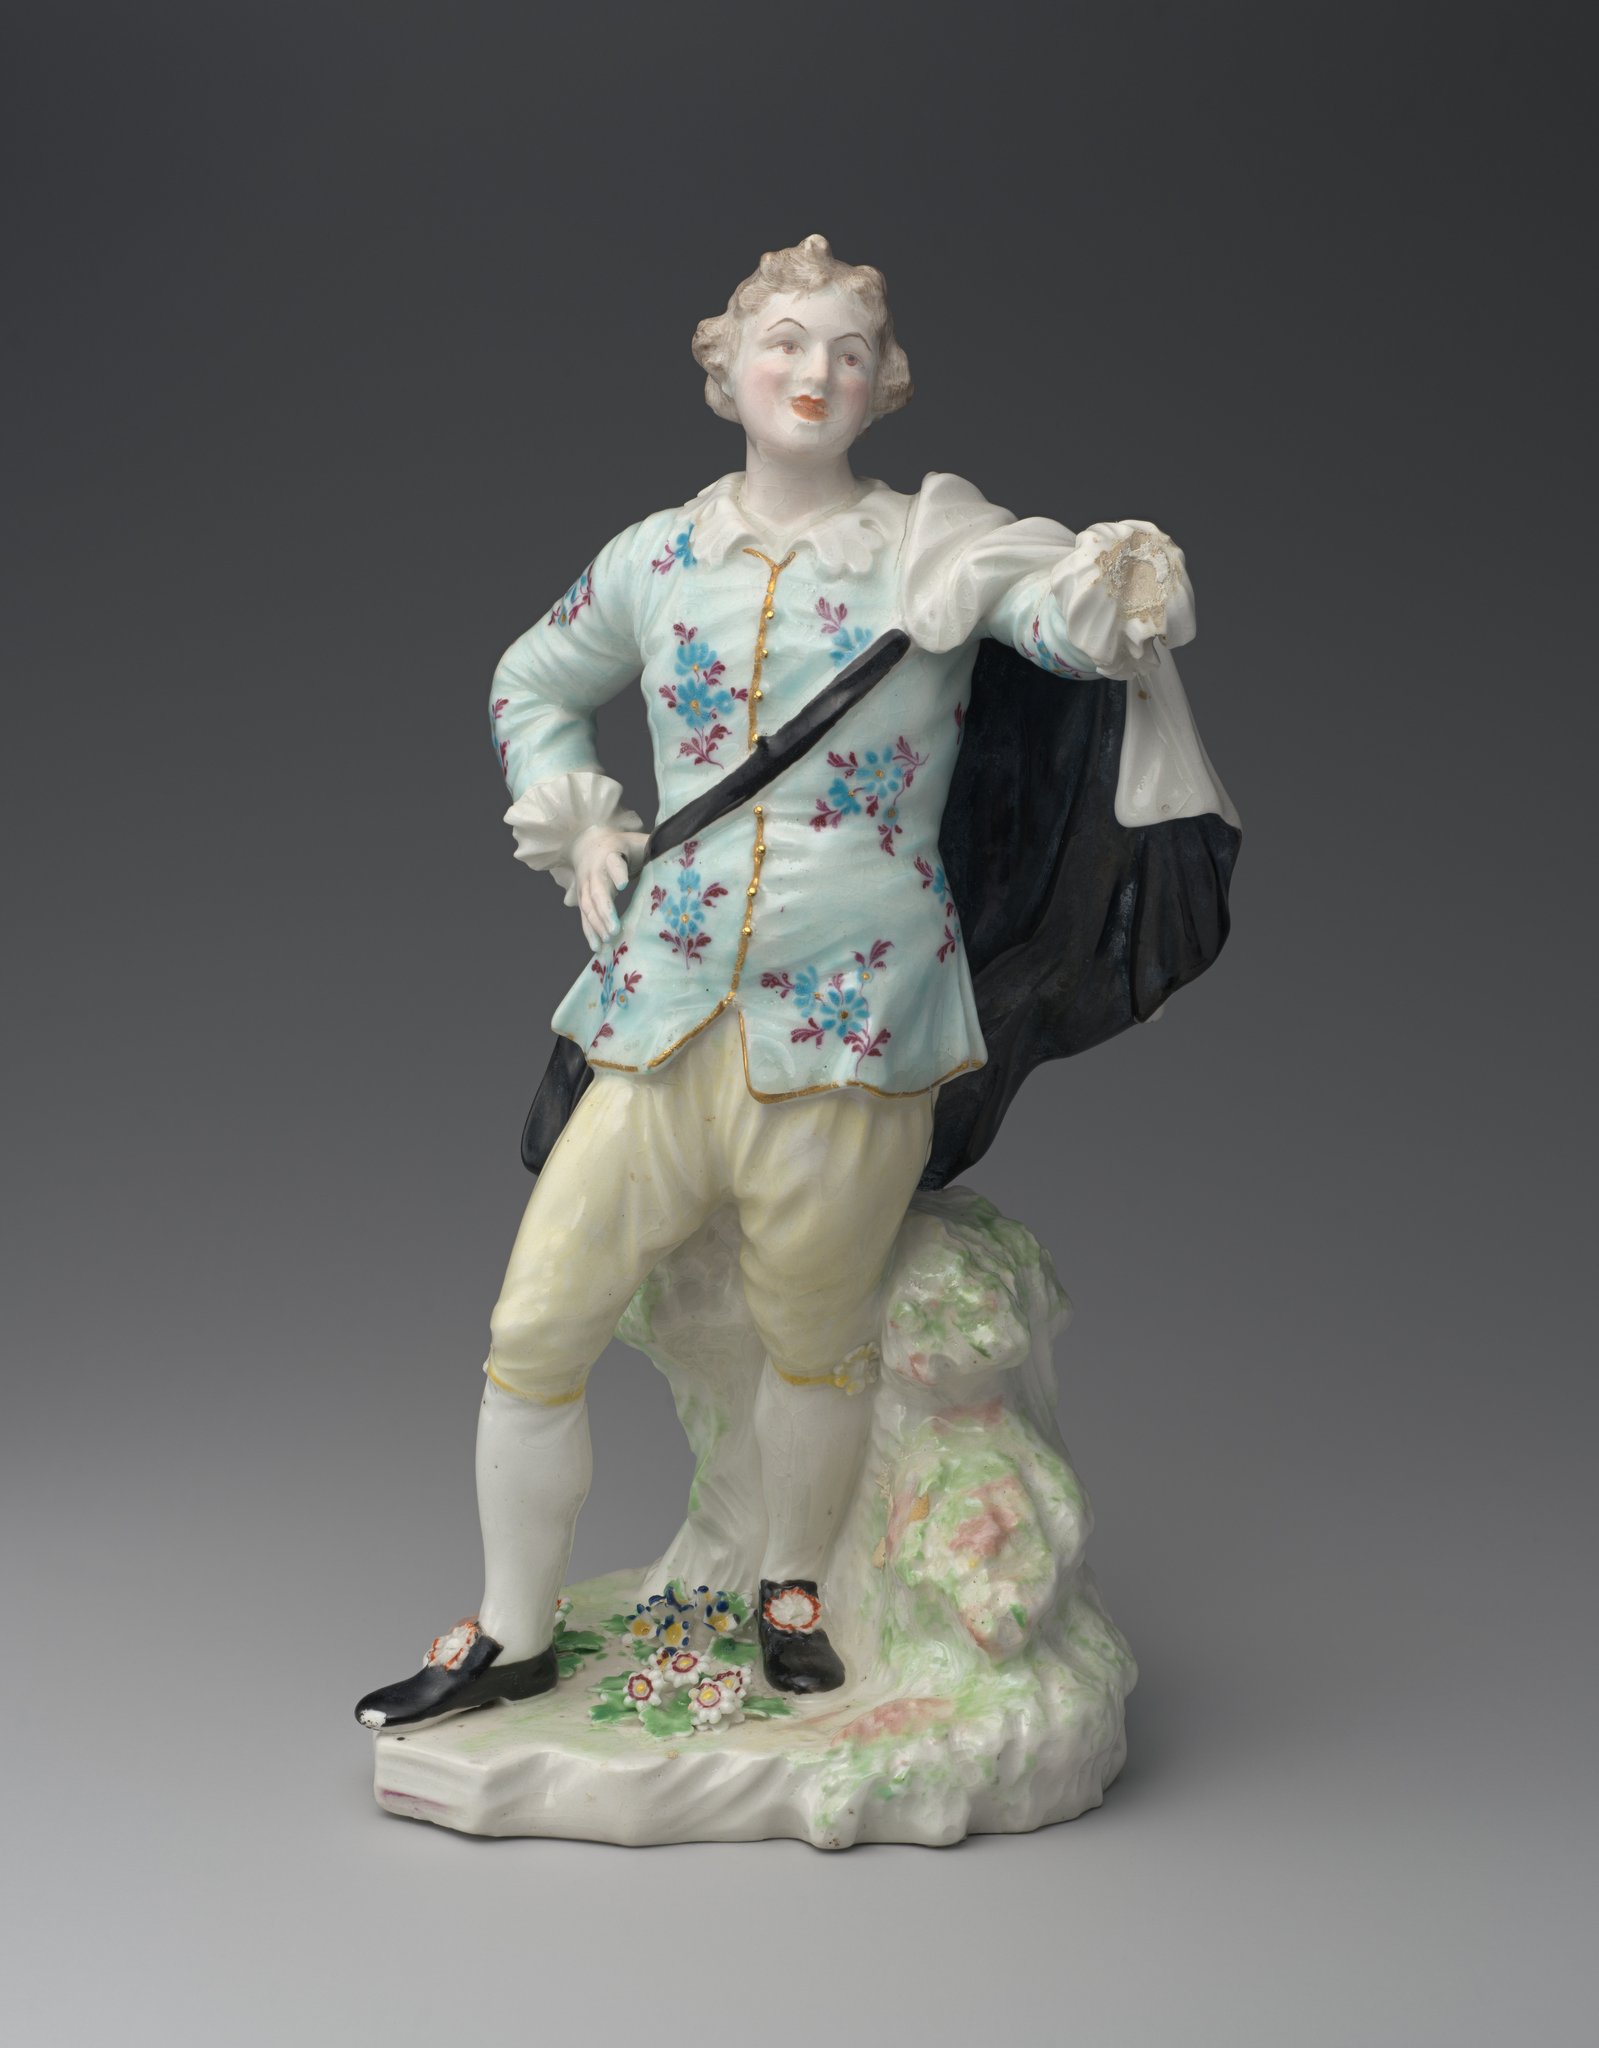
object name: figure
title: Musician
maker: chelsea porcelain manufactory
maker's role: factory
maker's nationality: british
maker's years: 1744-1784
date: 1775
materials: soft paste porcelain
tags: musicians